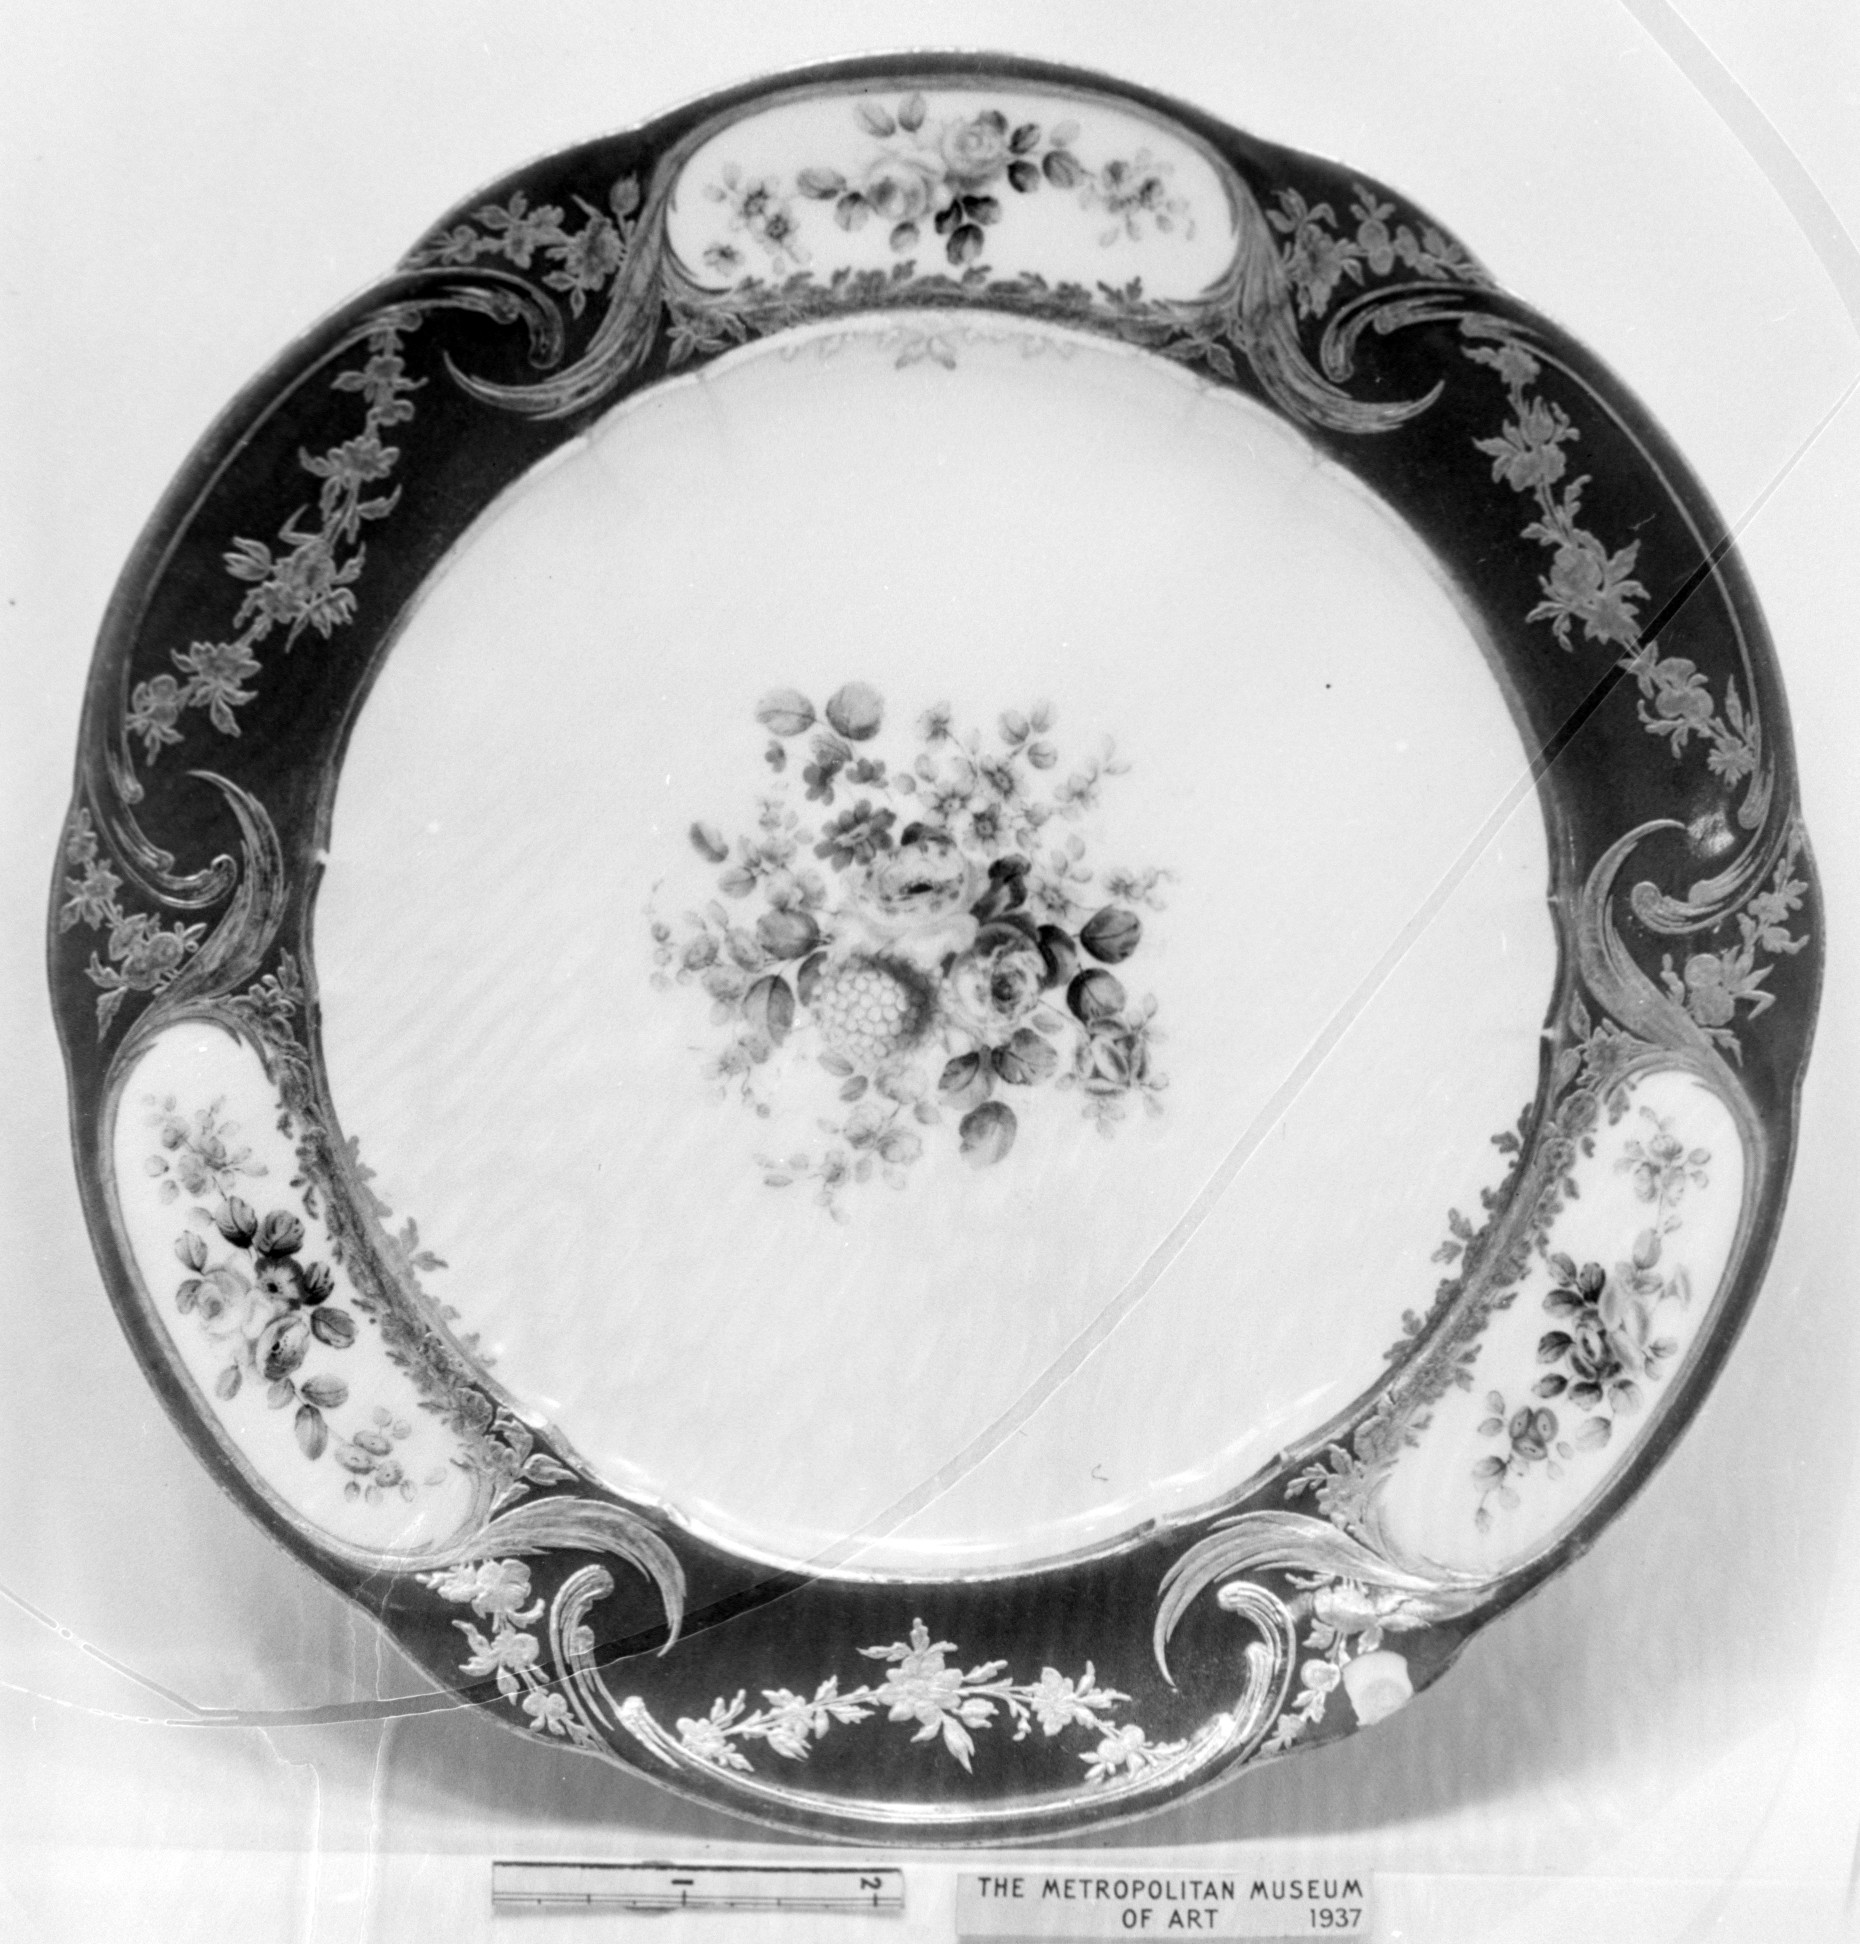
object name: plate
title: Plate (Assiette à palmes) (1 of 102) (part of a service)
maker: sèvres manufactory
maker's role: manufactory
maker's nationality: french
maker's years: 1740-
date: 1767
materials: soft paste porcelain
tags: flowers